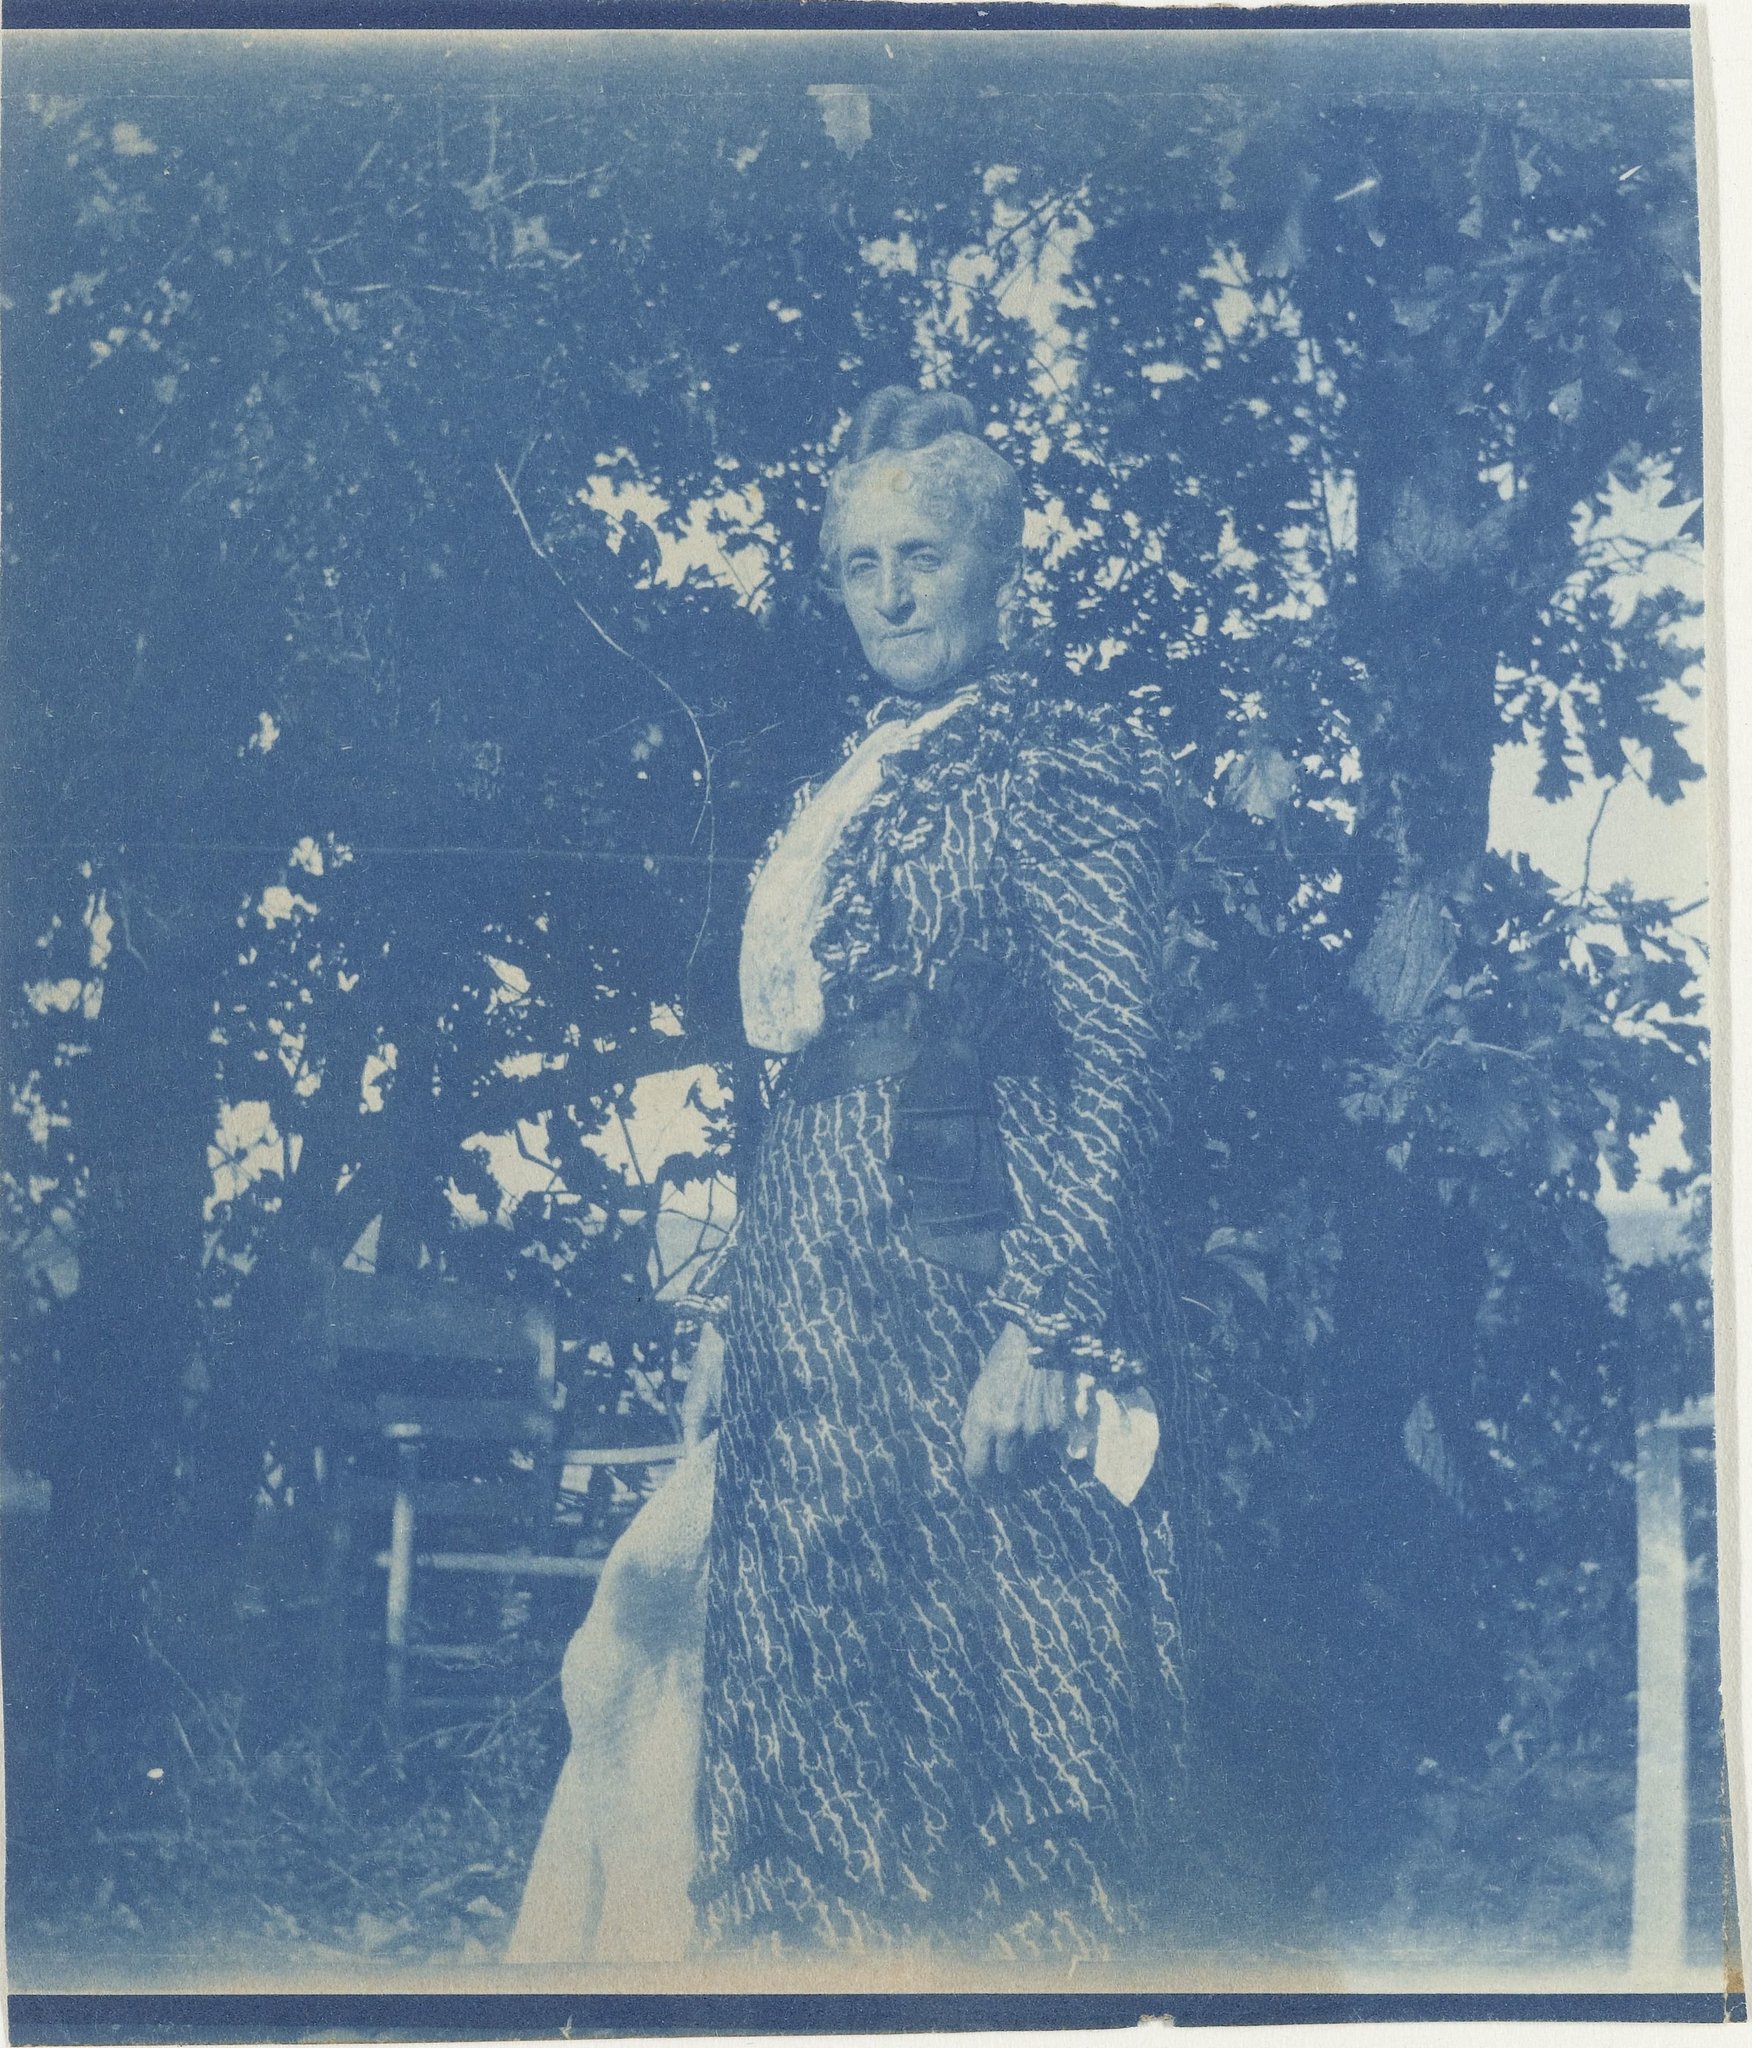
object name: photograph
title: Portret van een onbekende oude vrouw, staand in een tuin of park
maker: Anonymous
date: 1880-1910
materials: paper, photographic support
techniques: cyanotype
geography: new york city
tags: trees, historical persons - bb - woman